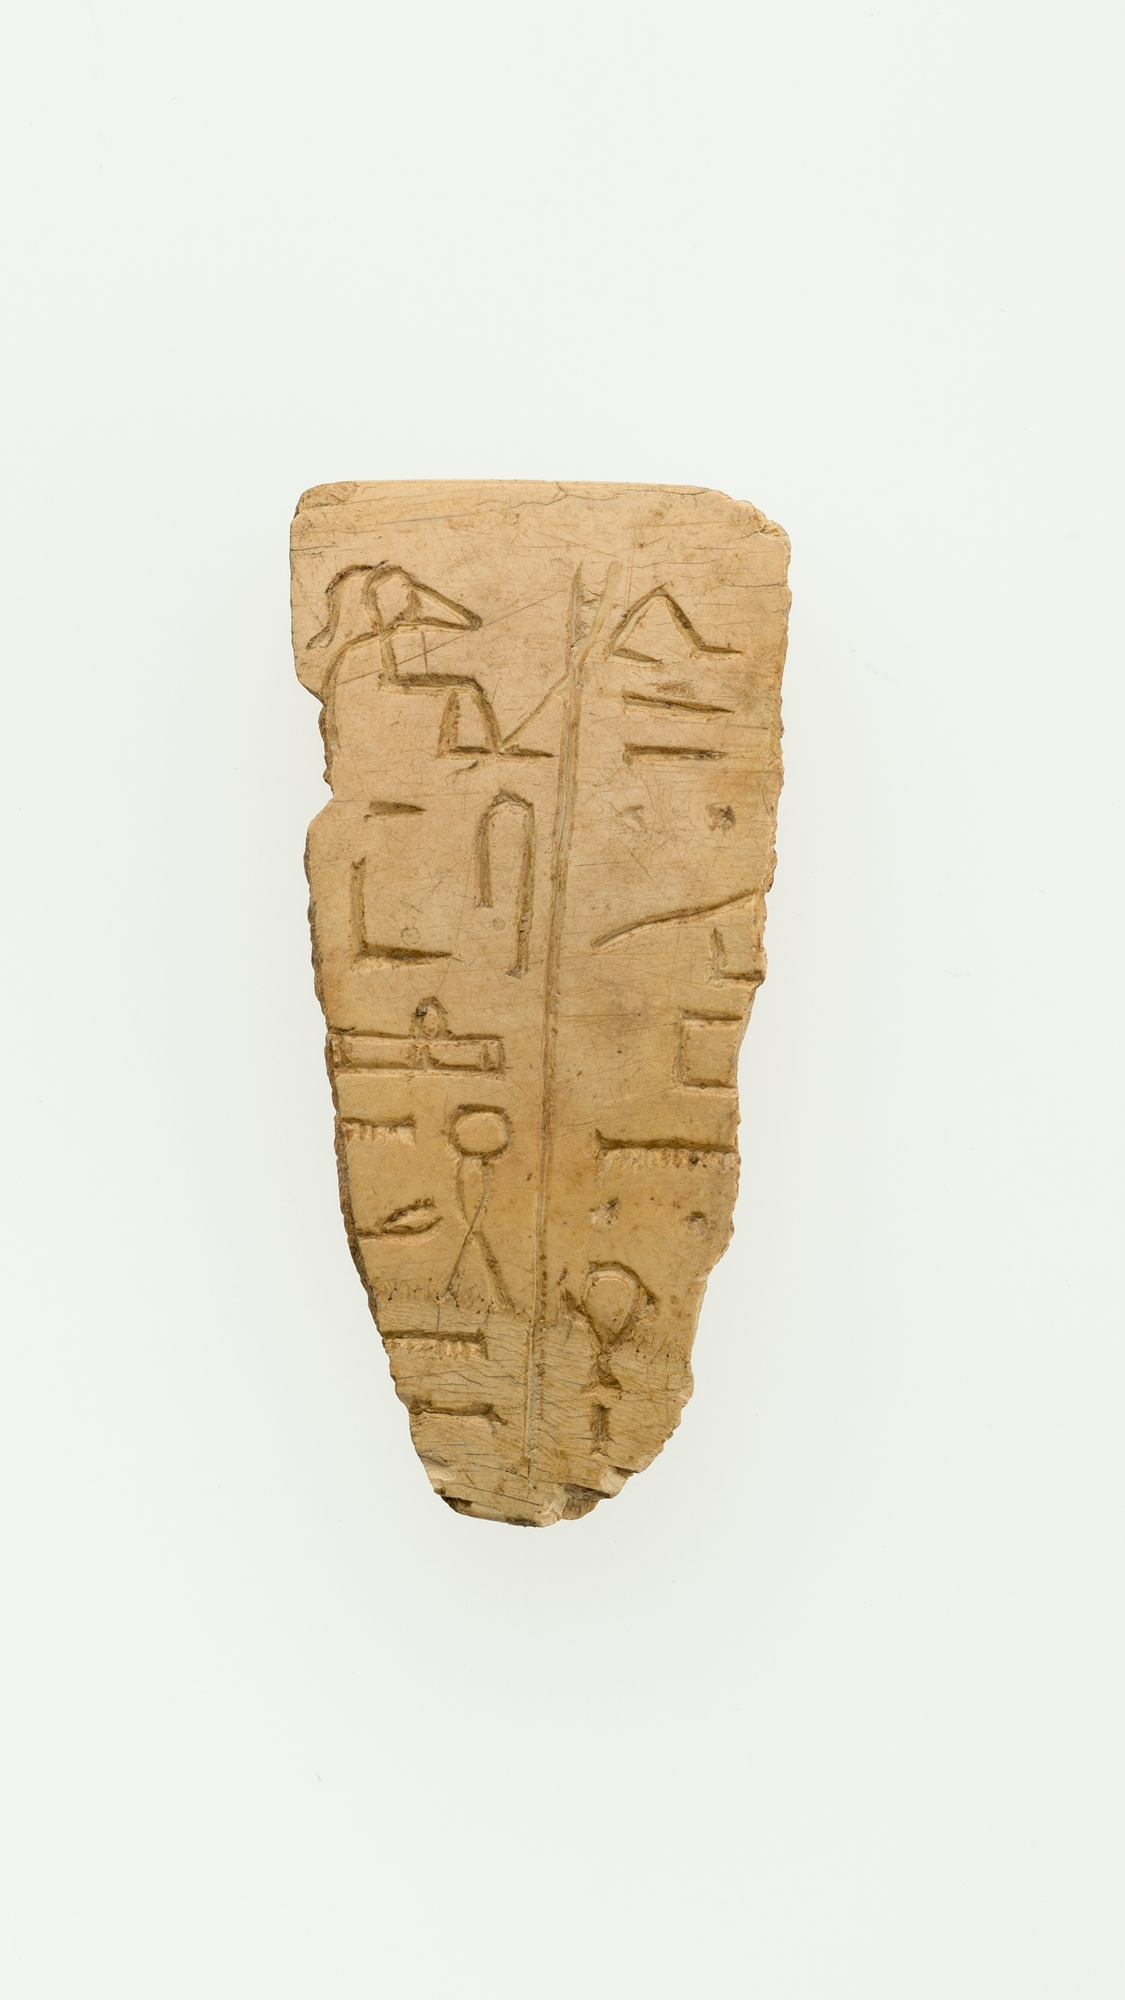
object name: magic wand fragment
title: A fragment of a magic wand illustrating a frog headed deity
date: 1981-1640 BCE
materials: ivory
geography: egypt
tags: hieroglyphs